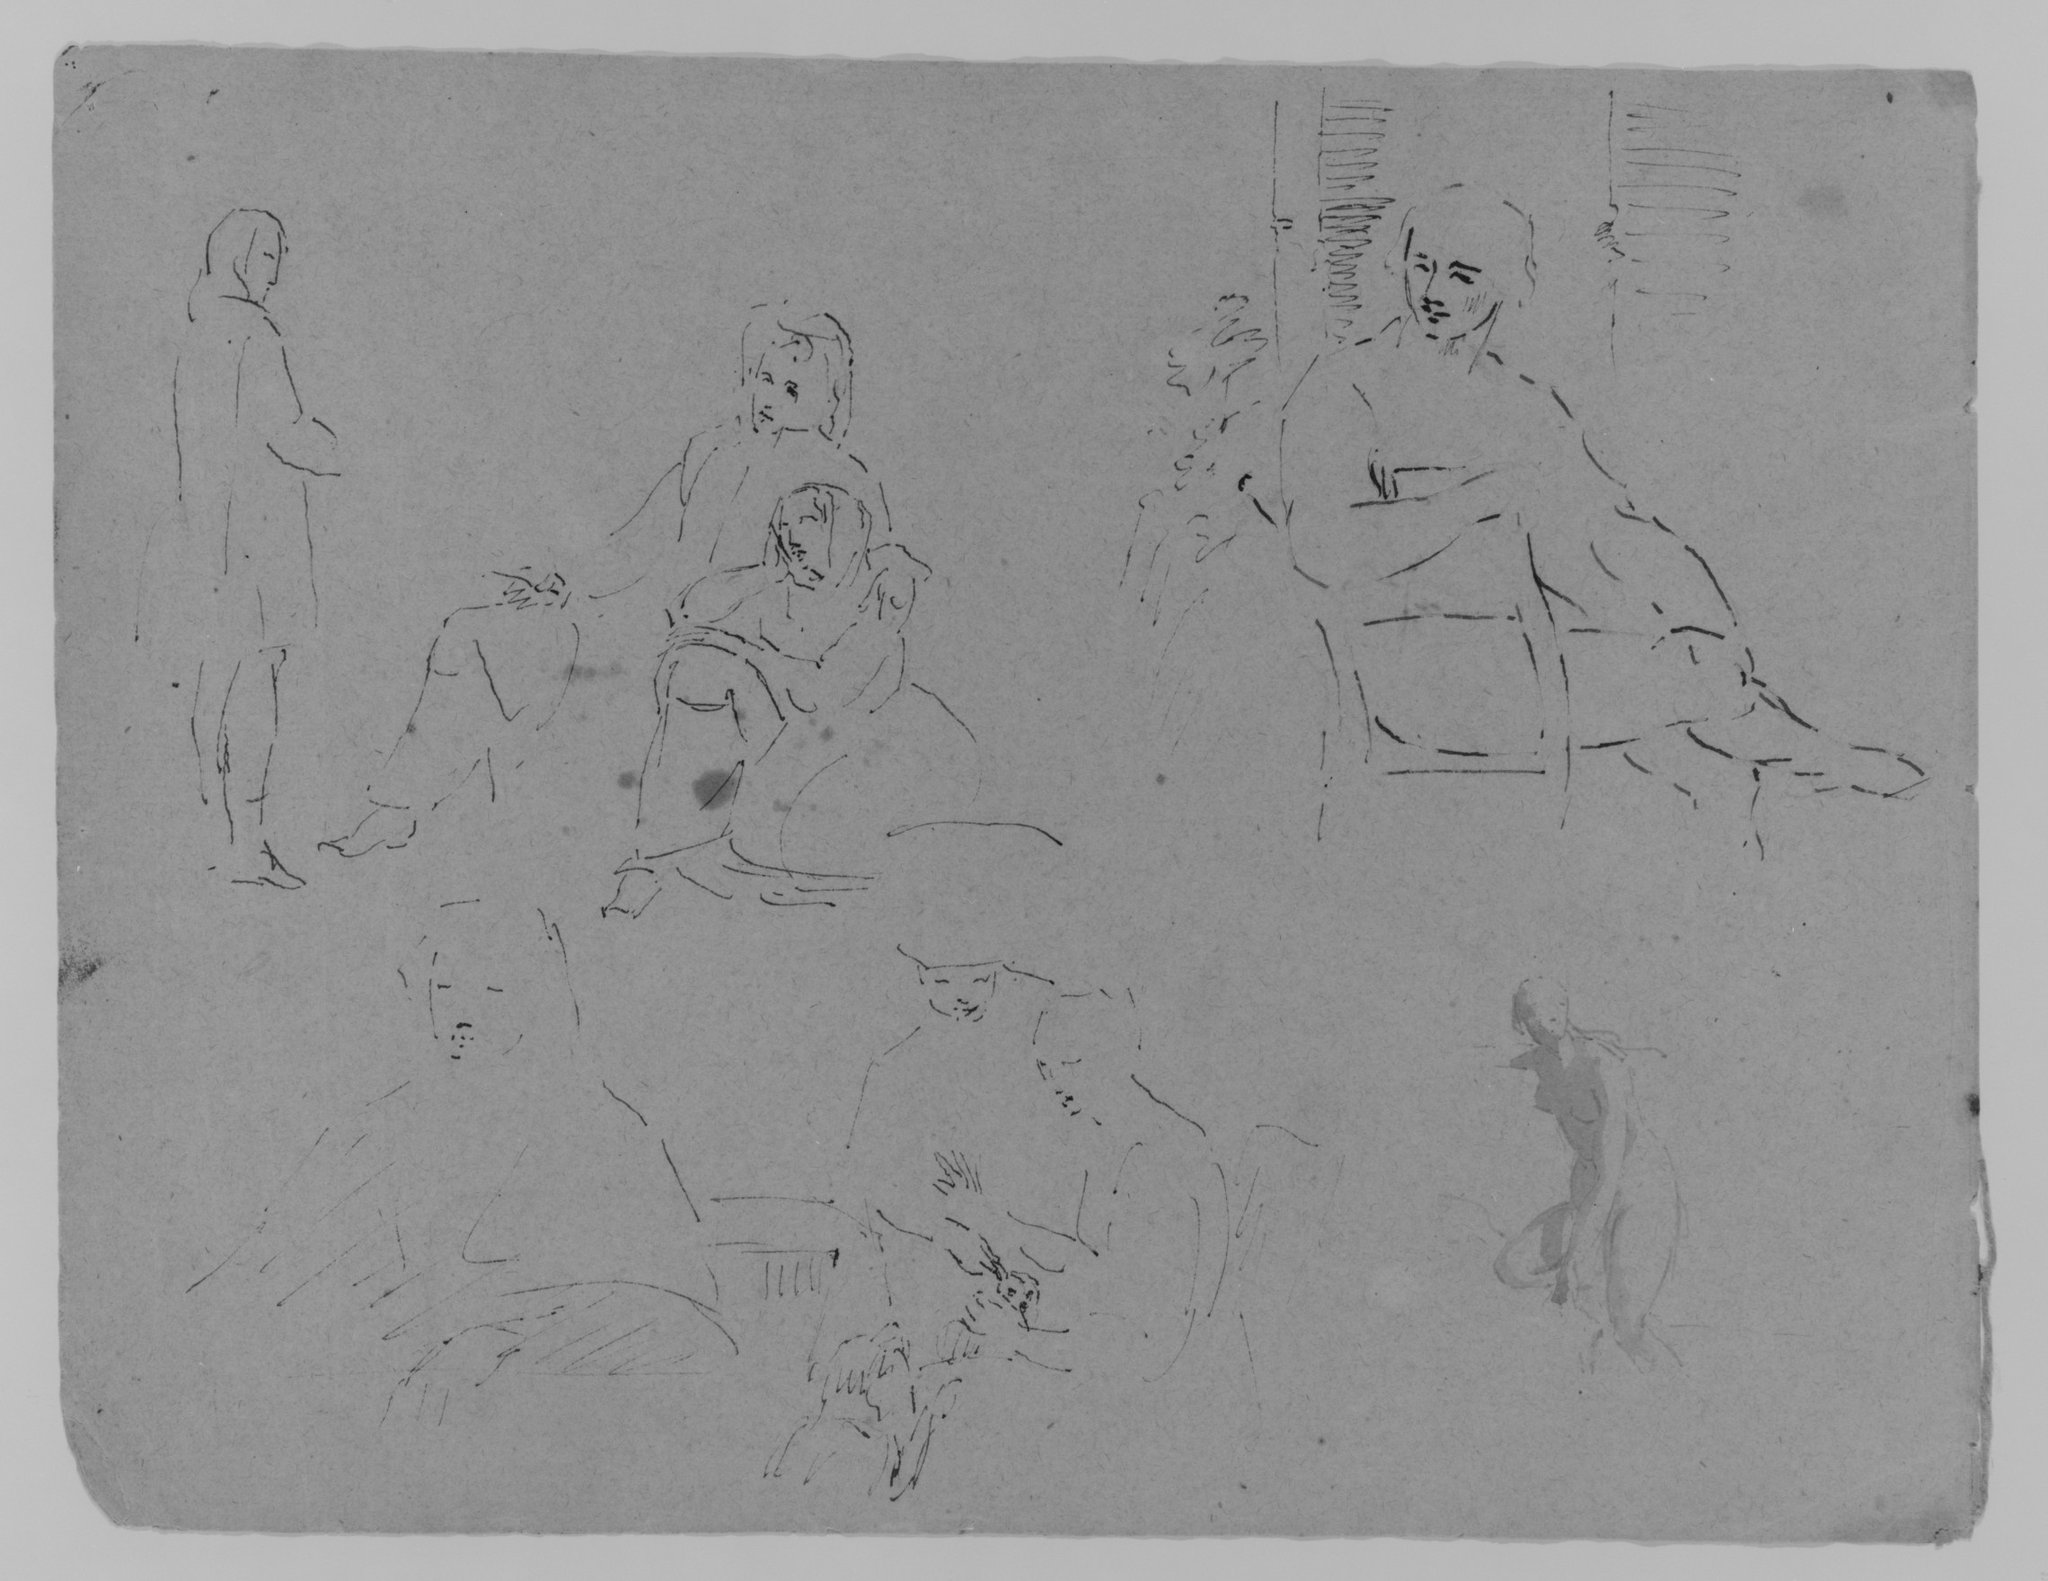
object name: drawing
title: (From Sketchbook)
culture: american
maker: thomas sully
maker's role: artist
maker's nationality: american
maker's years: 1783-1872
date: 1810-1820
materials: ink, paper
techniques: wash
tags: men,women